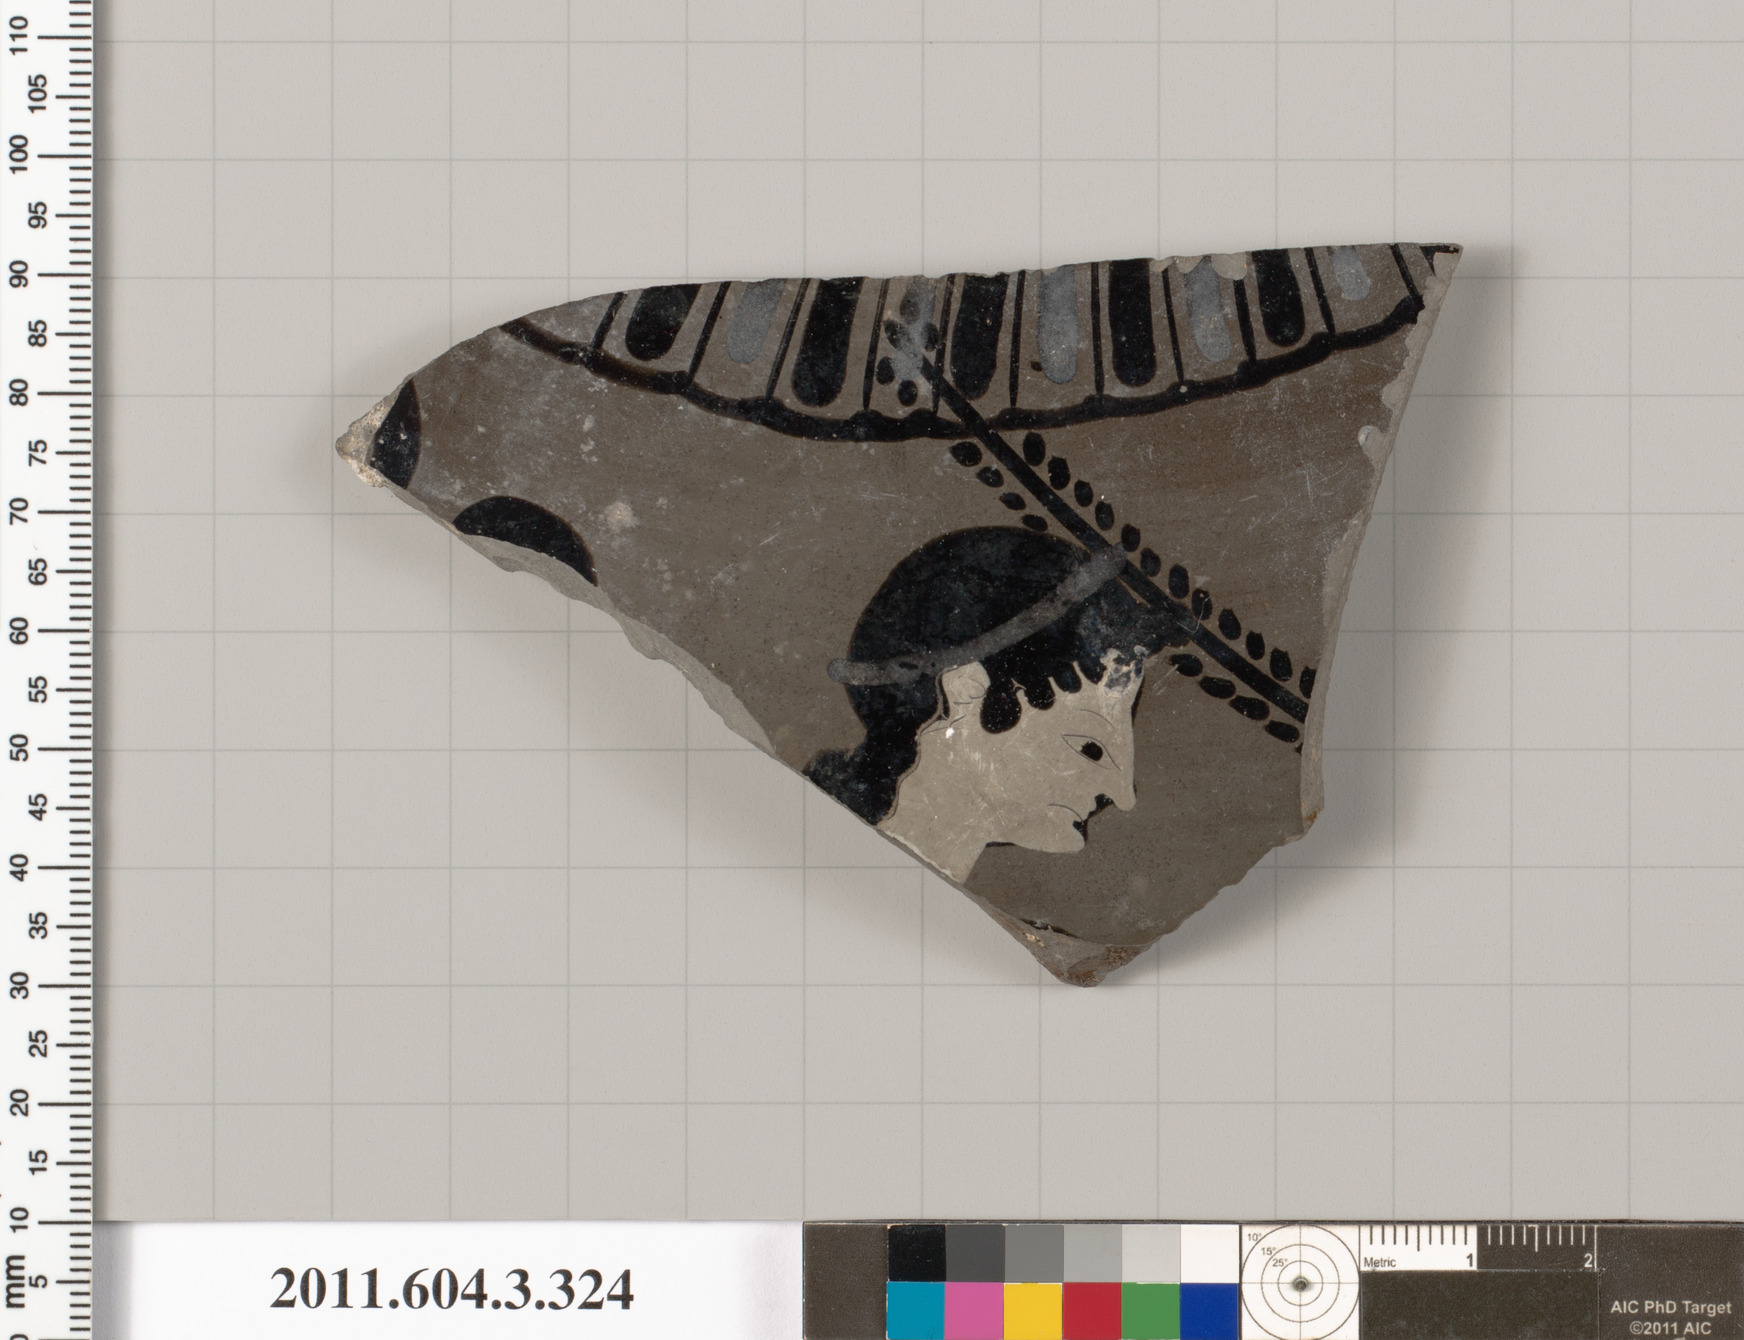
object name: neck amphora fragment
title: Terracotta fragment of a neck-amphora (jar)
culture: greek, attic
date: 540-530 BCE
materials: terracotta